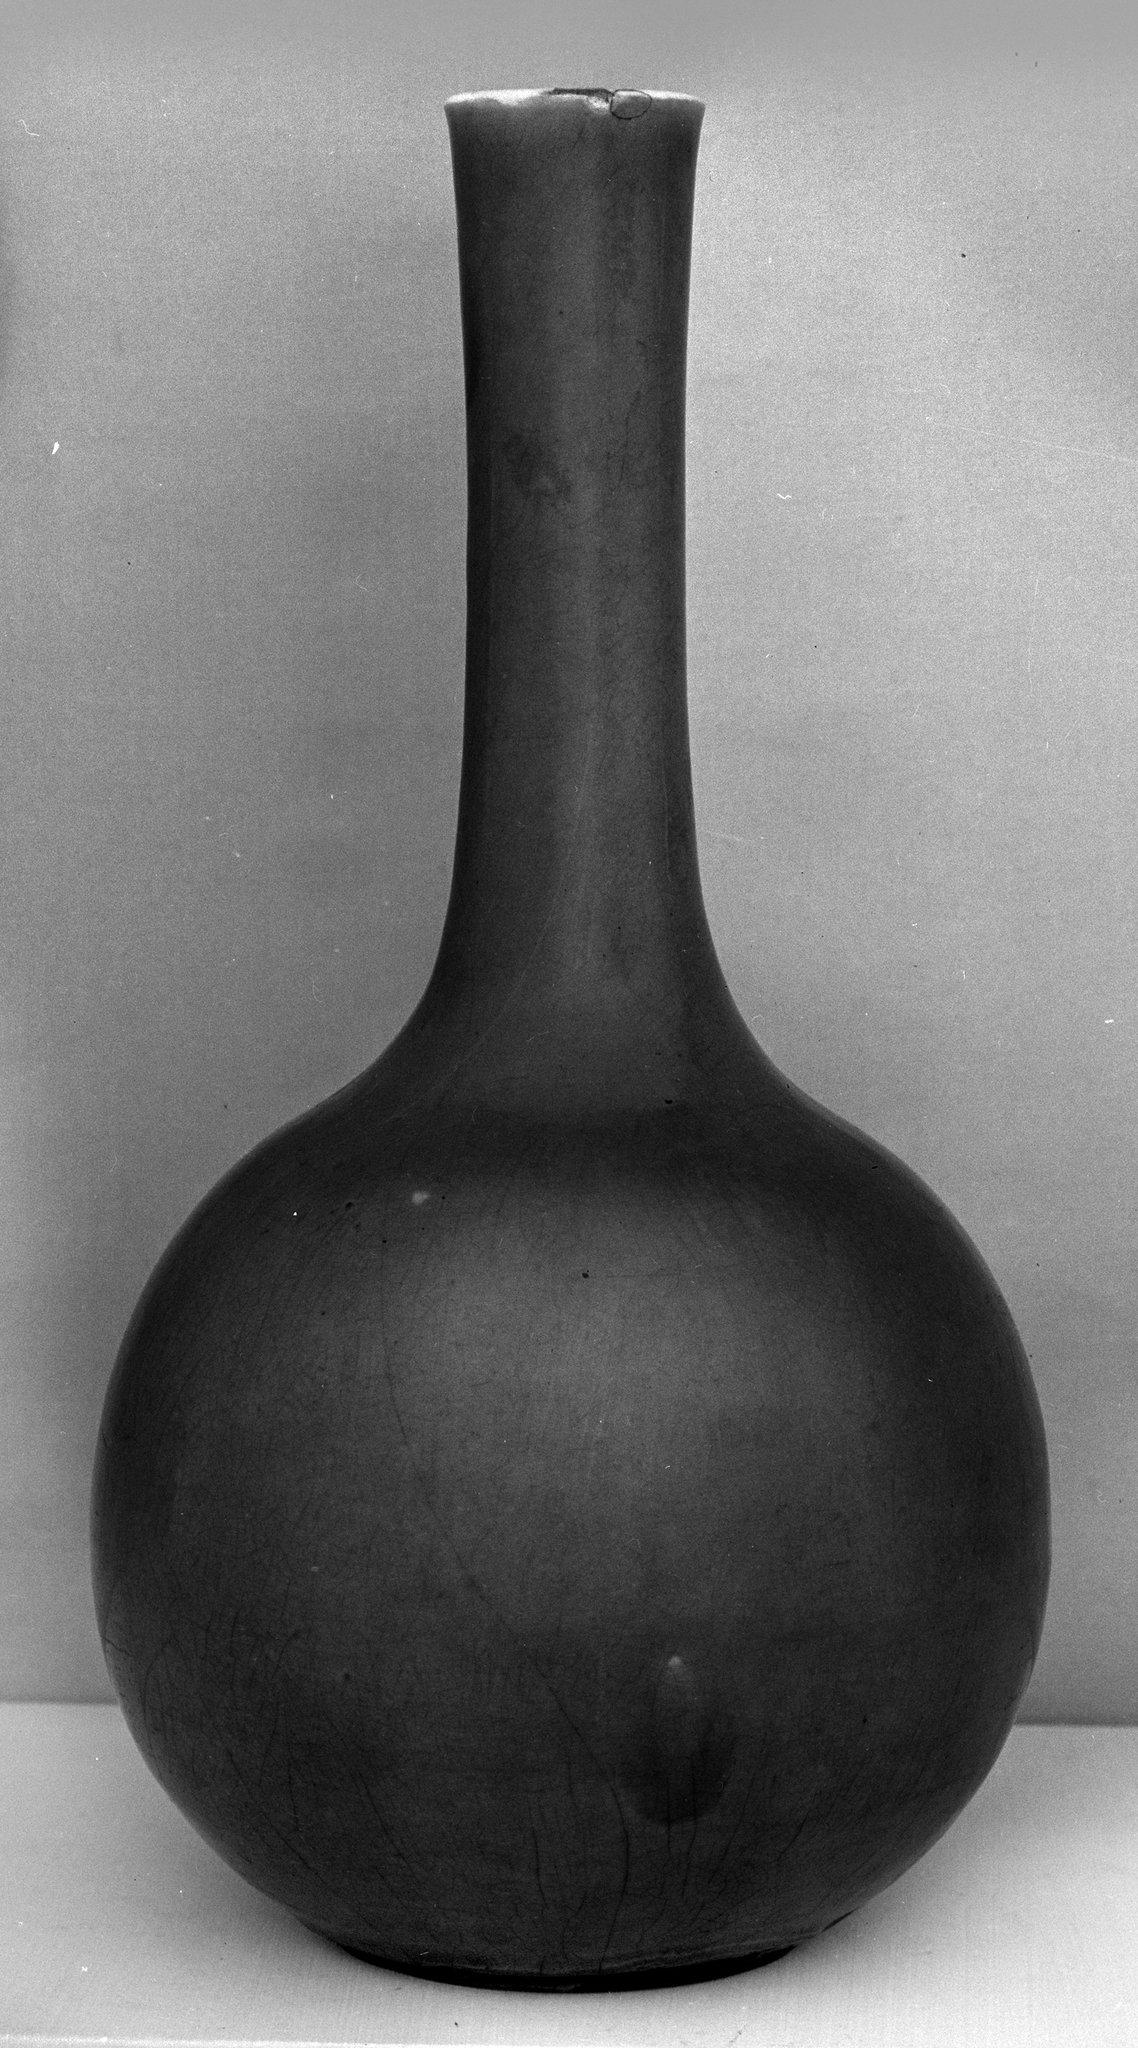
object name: bottle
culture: chinese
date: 1368-1644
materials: porcelain